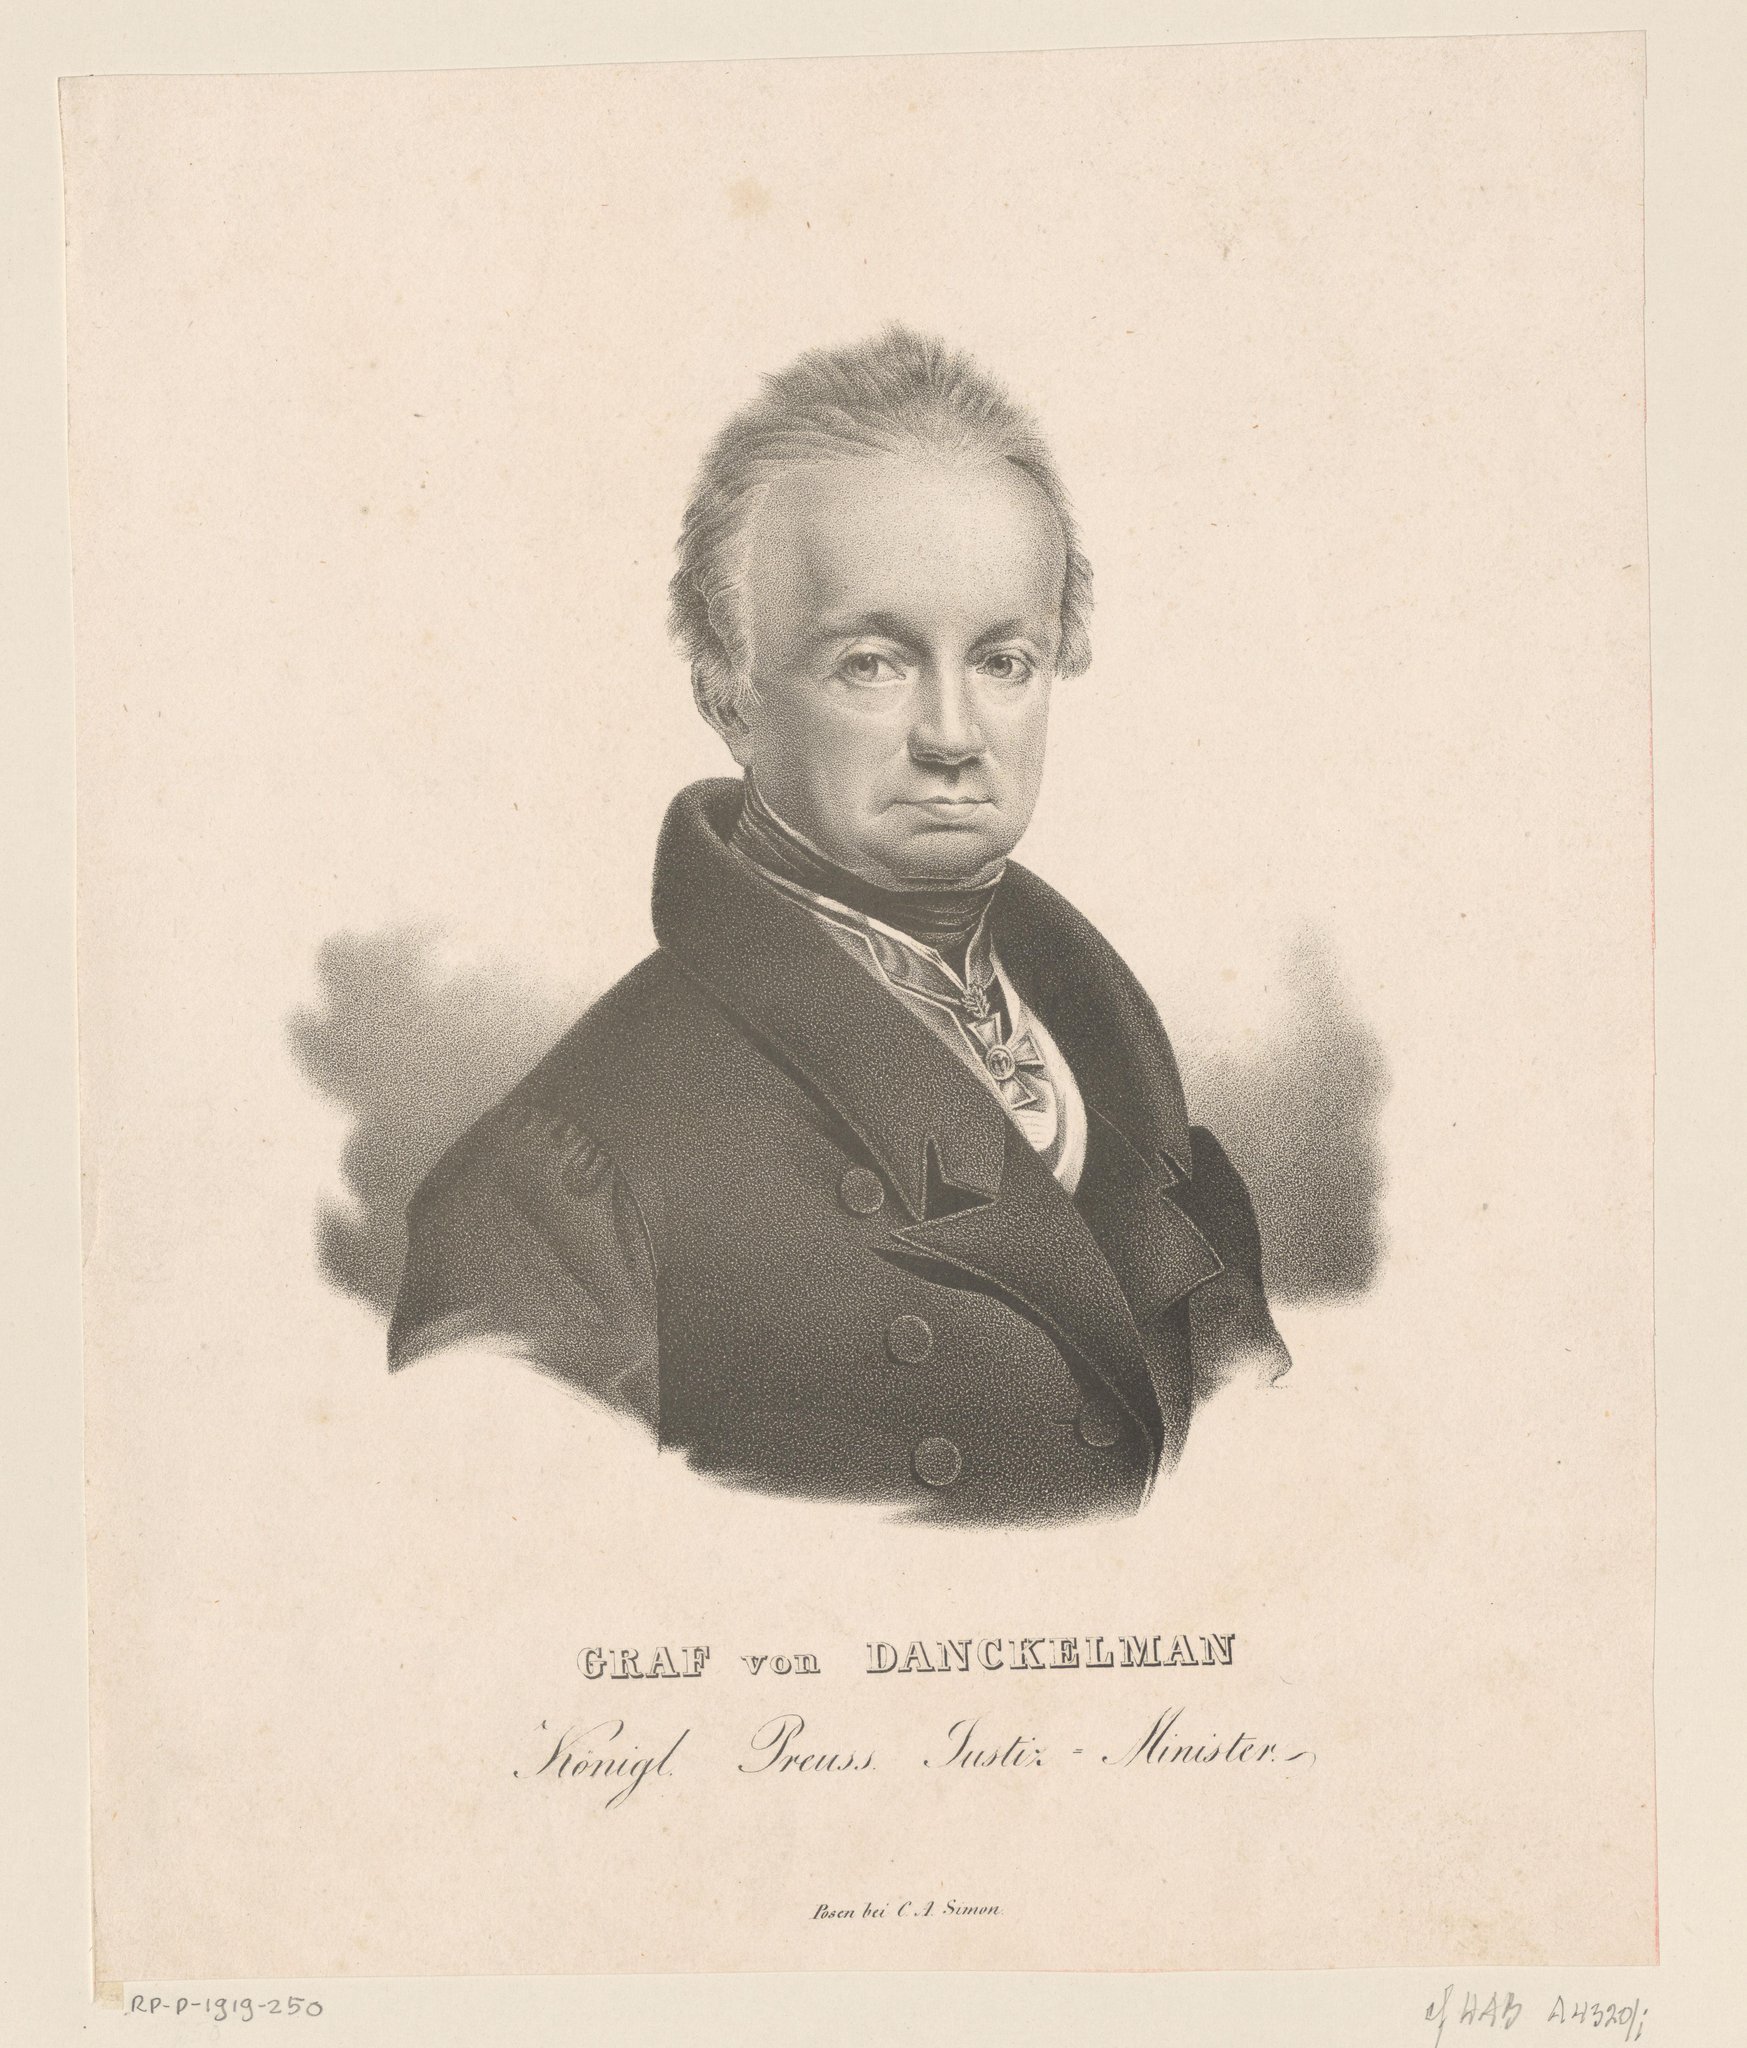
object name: print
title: Portret van Heinrich Wilhelm August Alexander, graaf van Danckelmann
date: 1825-1870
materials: paper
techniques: lithograph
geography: poznan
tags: cleves, minister ~ government, knighthood order (with name) - insignia of a knighthood order, e.g.: badge, chain (with name of order), historical persons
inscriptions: collector's mark: Lugt 2228